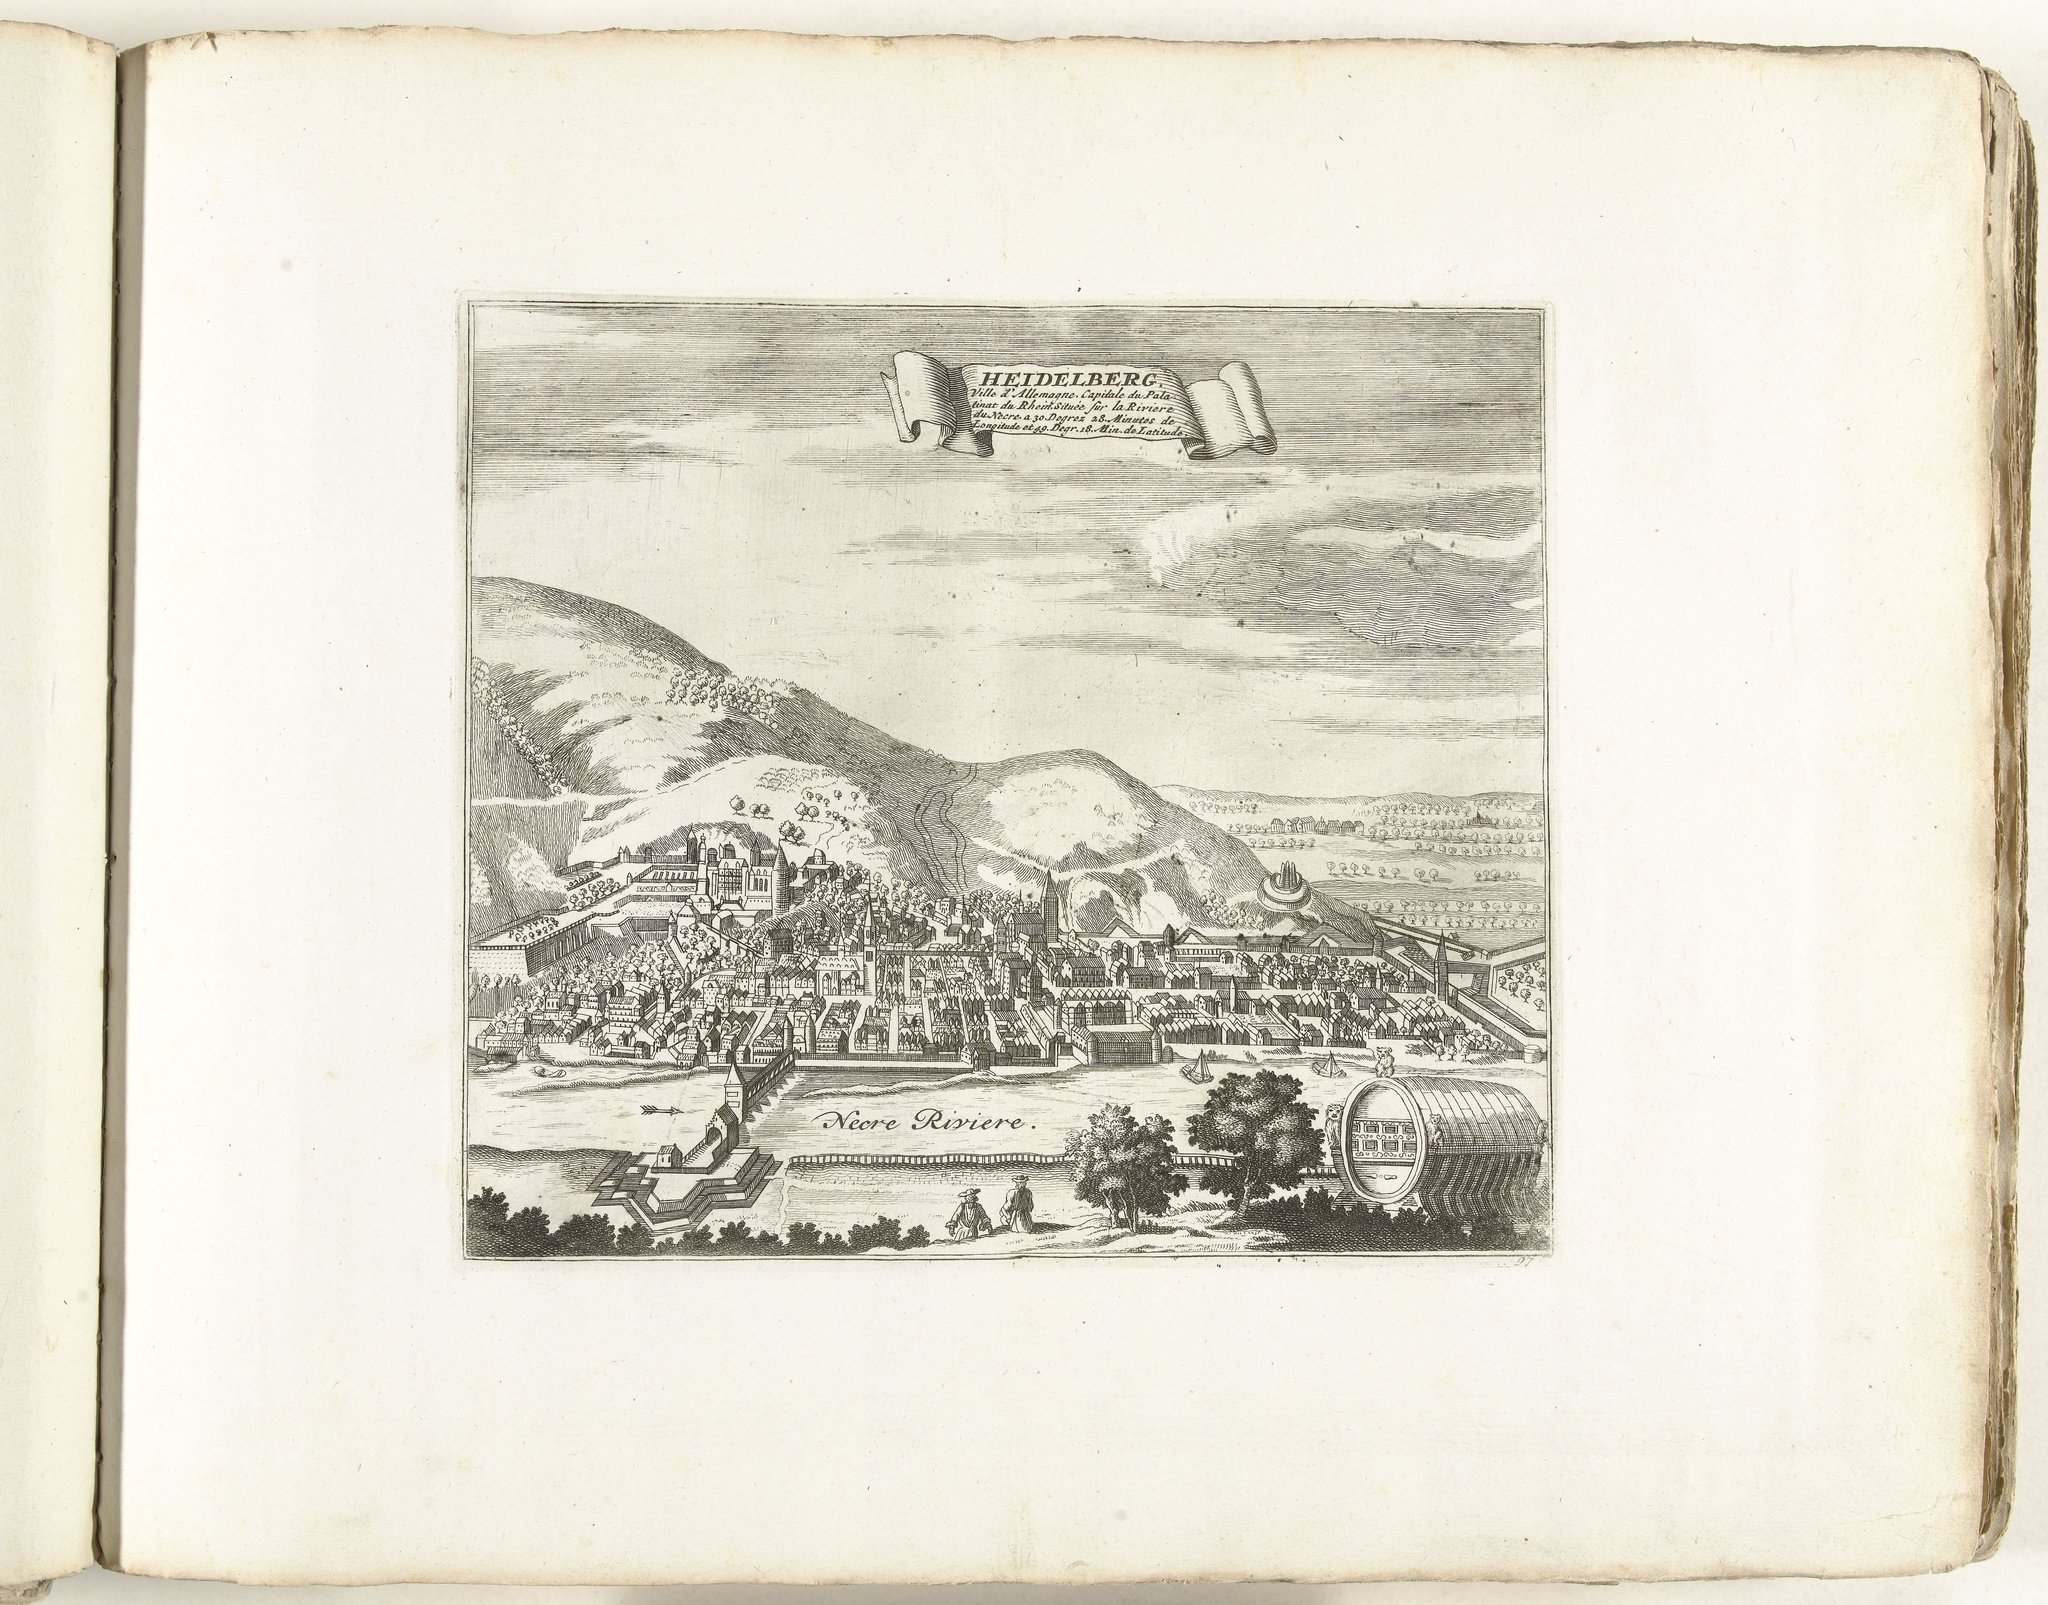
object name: map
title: Gezicht op Heidelberg, ca. 1702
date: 1702-1703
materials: paper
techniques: etching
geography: amsterdam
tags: heidelberg, spaanse successieoorlog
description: Gezicht op de Duitse stad Heidelberg, op de voorgrond het grote vat. Plaat nr. 97 in het prentwerk bestaande in totaal uit 276 genummerde platen van vermaarde sterke steden en vestingen in het kader van de Spaanse Successieoorlog. Voor het merendeel zijn deze platen gekopieerd naar de anonieme Franse platen: in Les forces de l'Europe en in: Le theatre de la guerre, dans les Pays-Bas, beide oorspronkelijk uitgegeven door Nicolas de Fer te Parijs (1693-1697) in het kader van de Negenjarige Oorlog. Titel en opschriften in de plaat in het Frans.